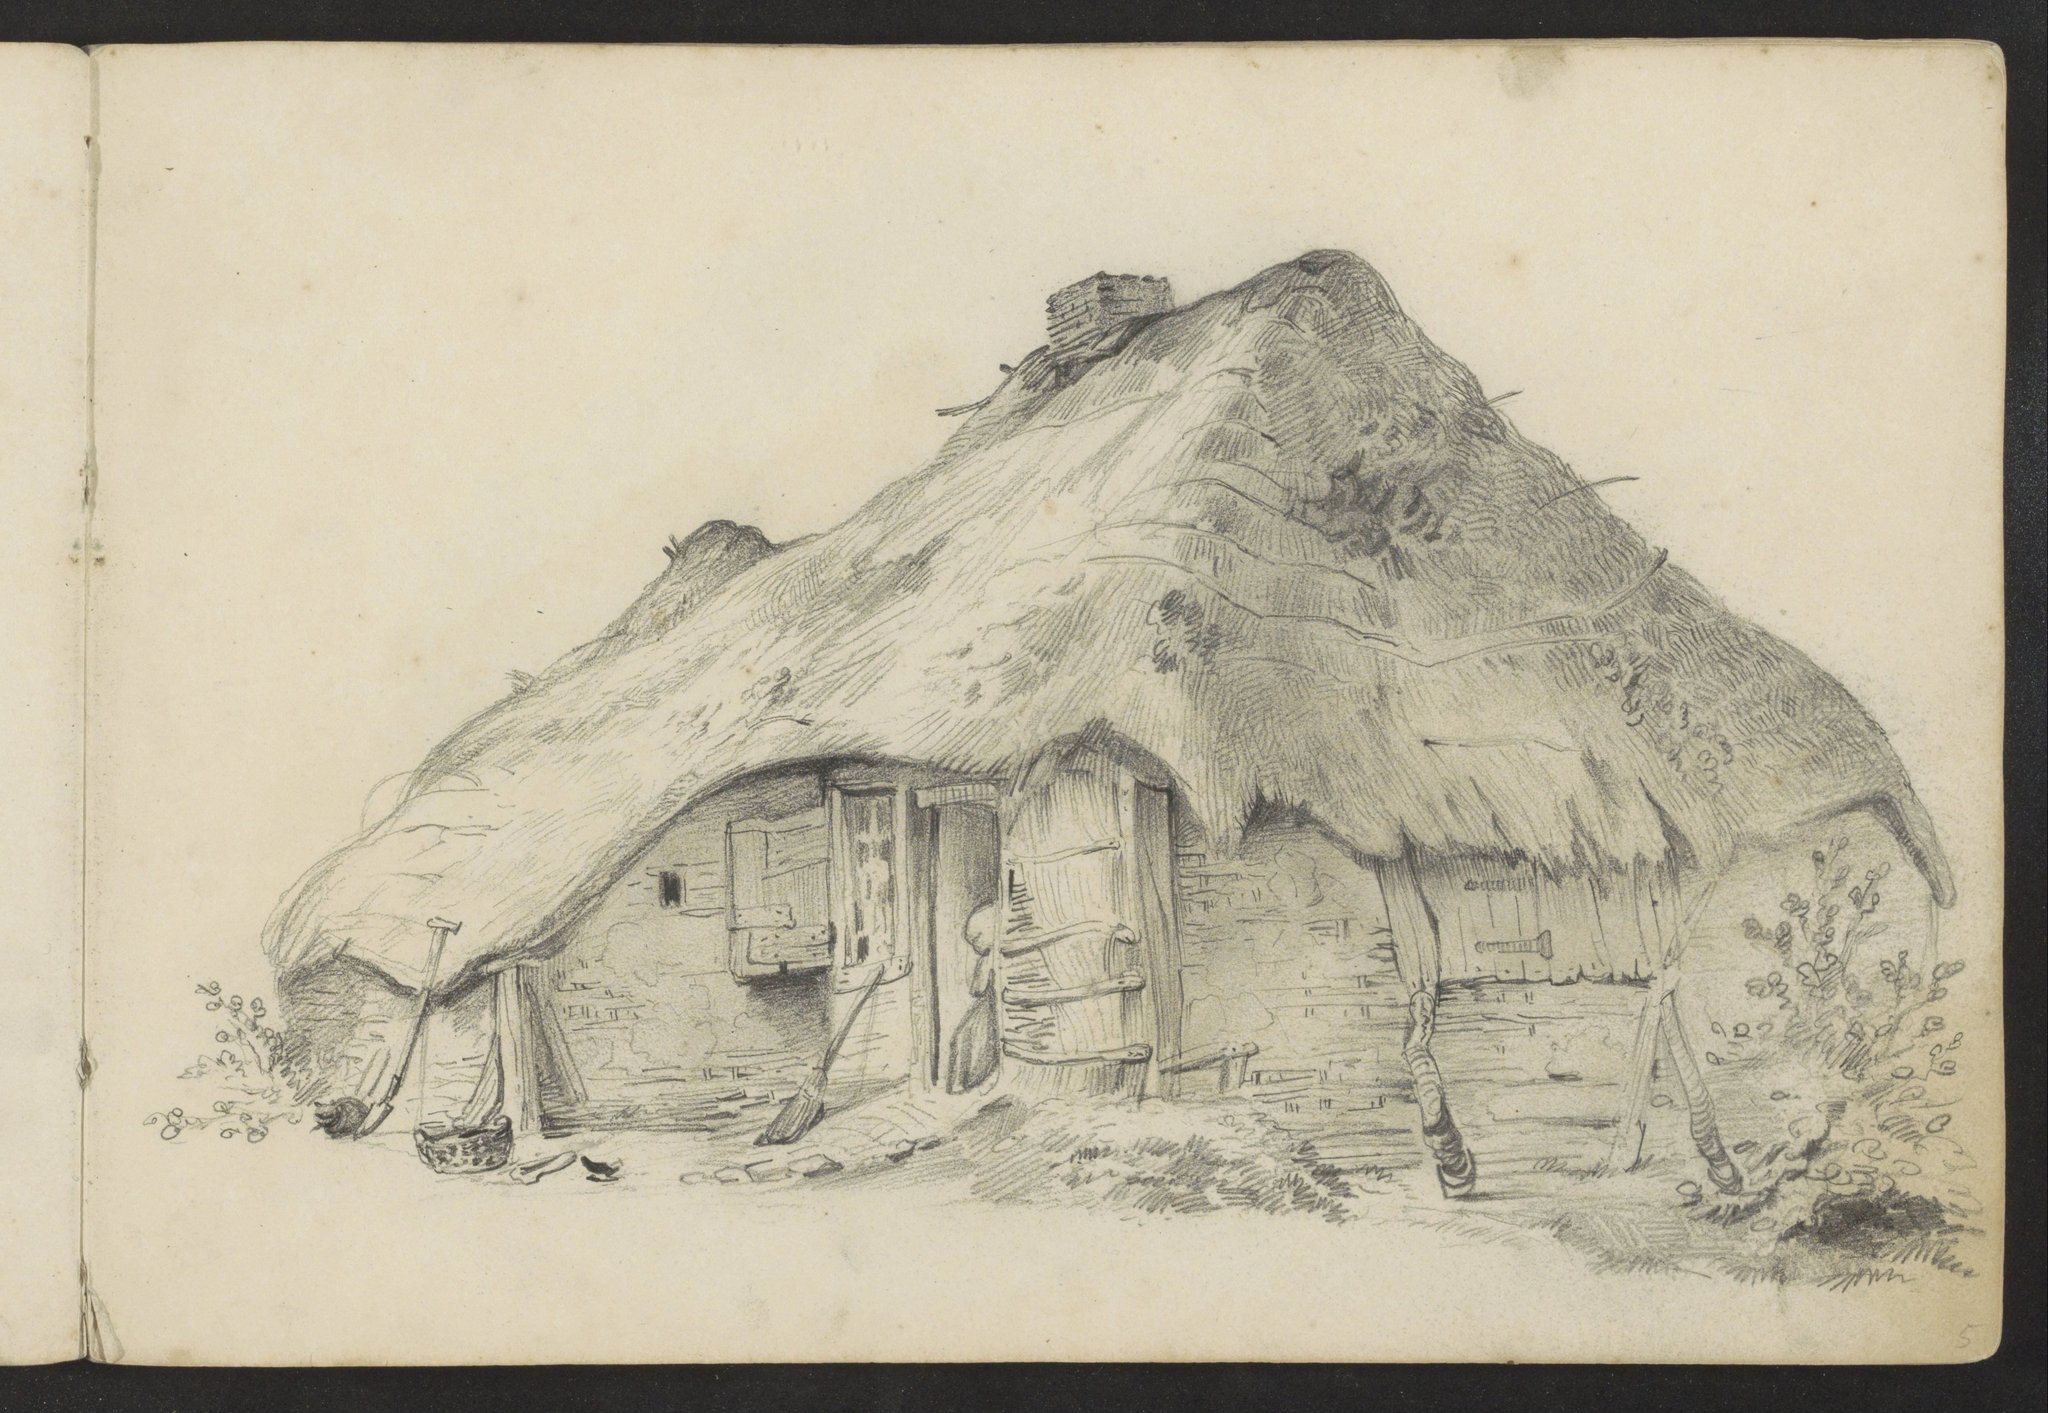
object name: sketchbook leaf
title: Boerenwoning met een rieten kap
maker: johannes tavenraat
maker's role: draughtsman, painter, print maker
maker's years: 1809-1881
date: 1842-1868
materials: paper, pencil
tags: rural housing, e.g. country-house, villa, cottage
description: Blad 5 recto uit een schetsboek met 45 bladen.